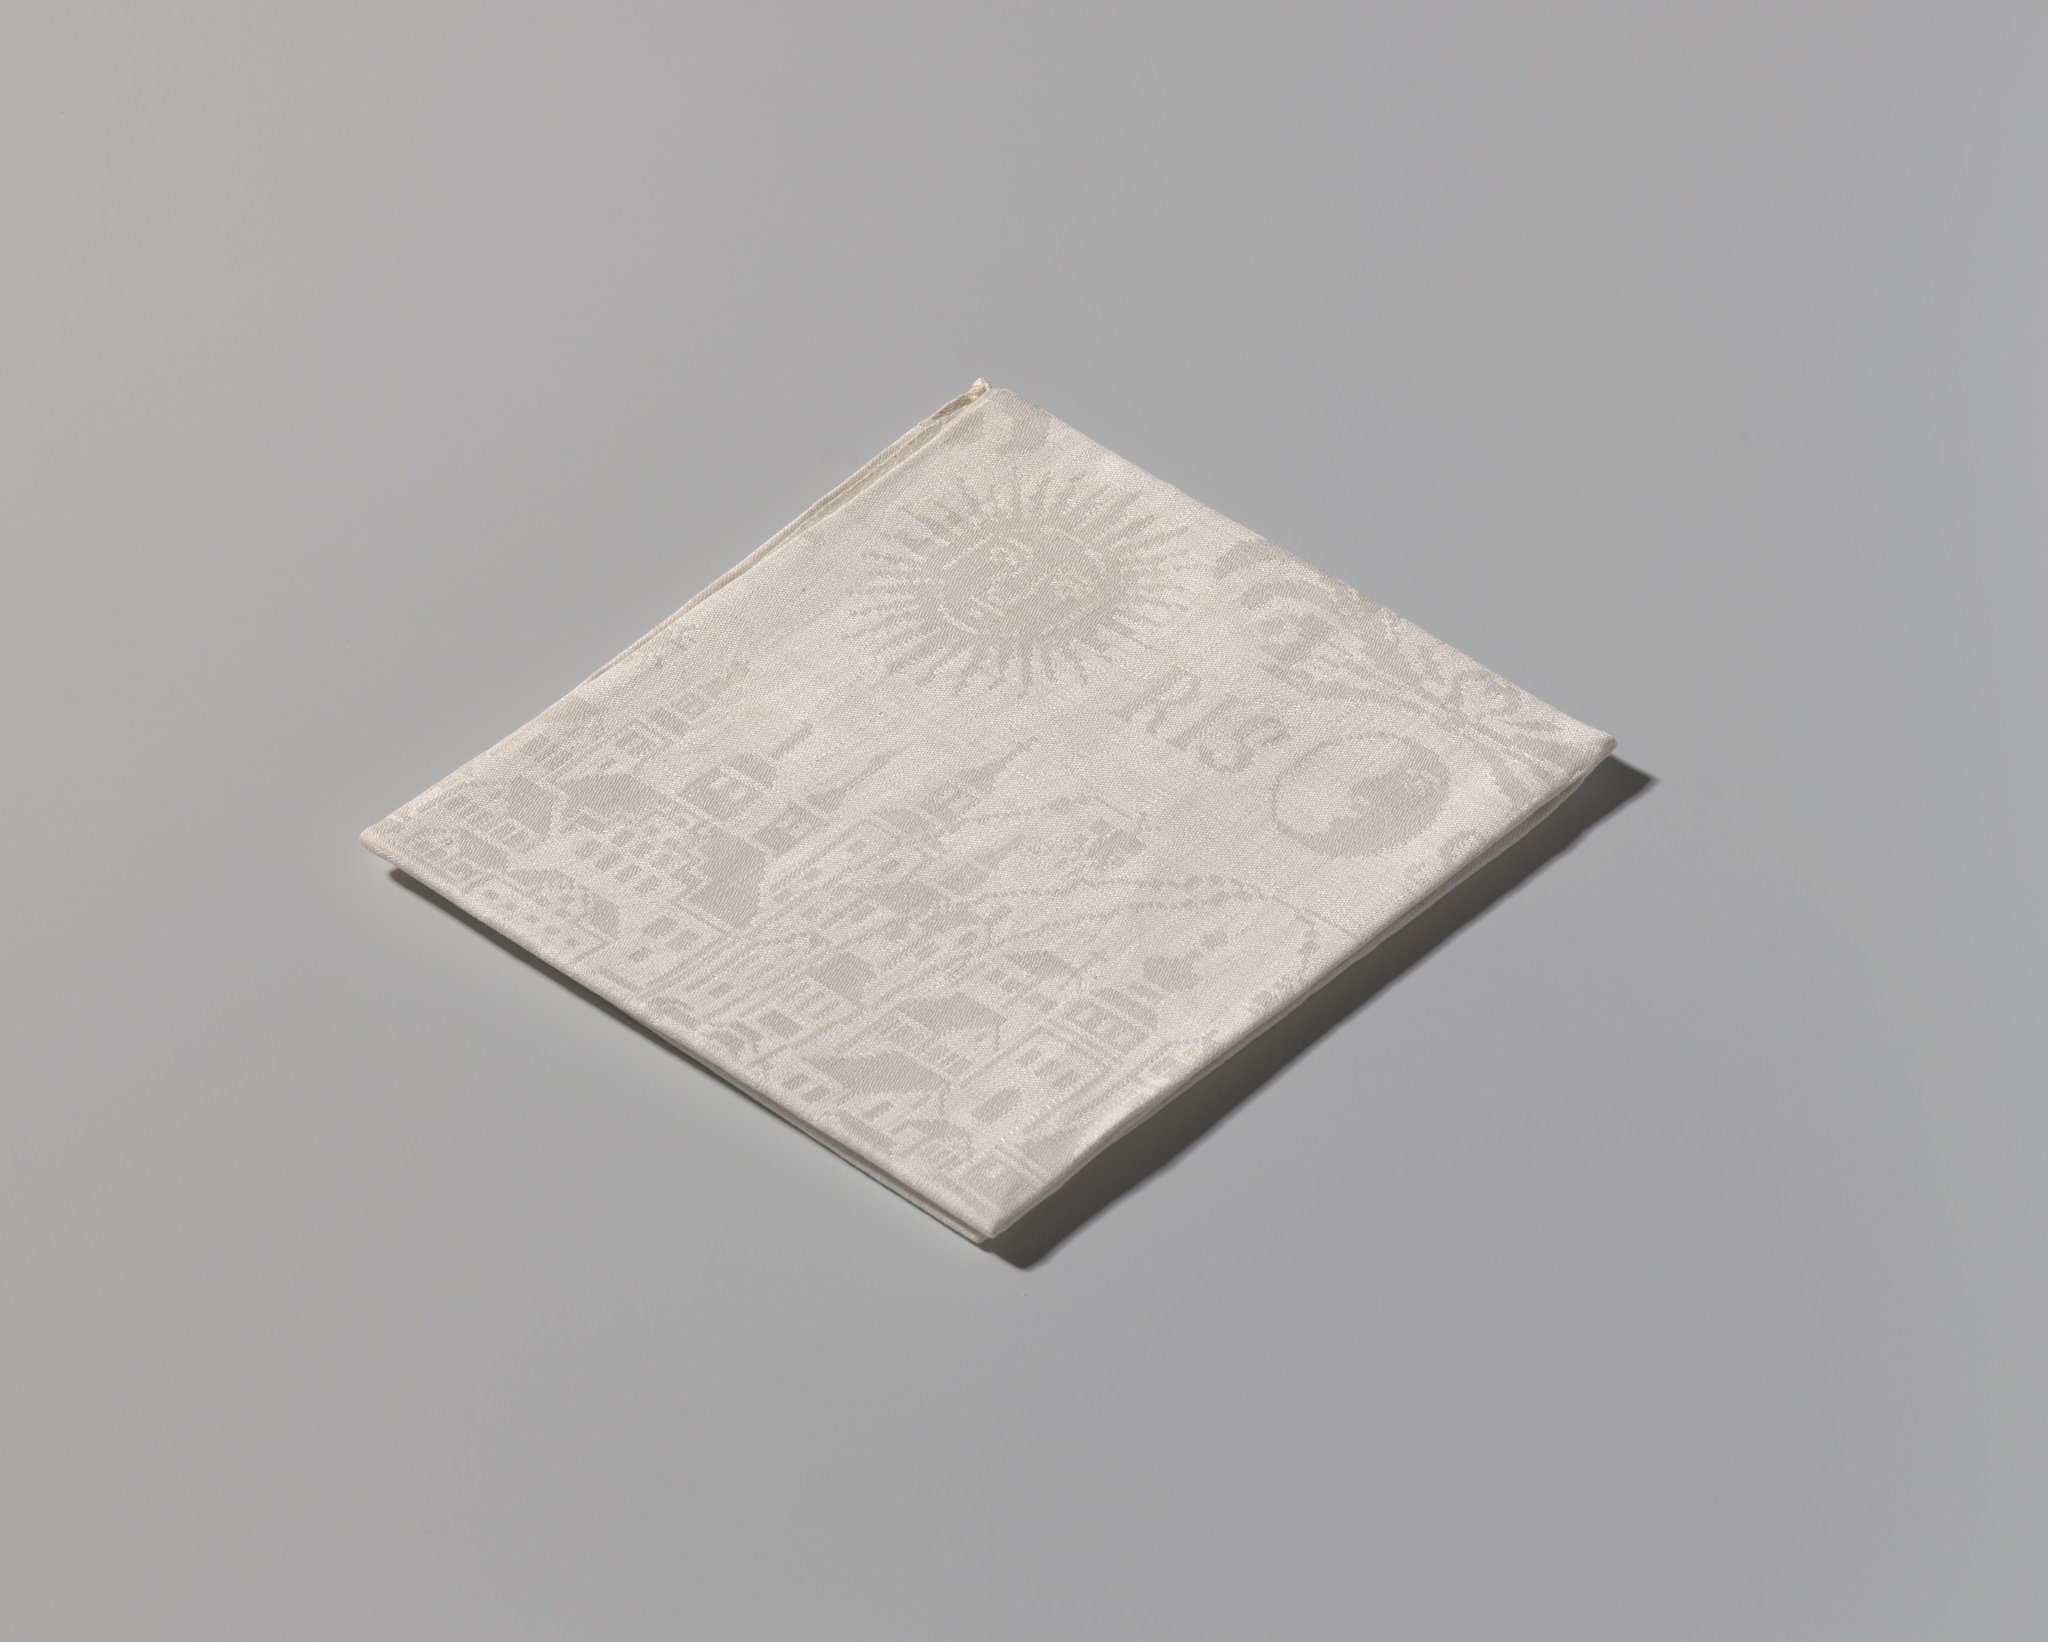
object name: tablecloth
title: Fragment van een tafellaken met de inname van Rijssel door Eugenius van Savoye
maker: Anonymous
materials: linen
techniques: damask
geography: kortrijk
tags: paris, vienna, eugenius van savoye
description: Fragment van een tafellaken van linnendamast met de inname van Rijssel door Eugenius van Savoye. Twee ruiters met het bijschrift: EGENIUS. In drie kransen de tekst: SISTE SOL IN GIBEON, ET LUNA IN VALLE...IA-ALON (Blijf staan, zon, te Gibeon en gij, maan, in het dal van Ajalon, Josua 9:13), de zon en de maan en het bijschrift: RIS-SEL. Staande randen: Doorlopende ranken.